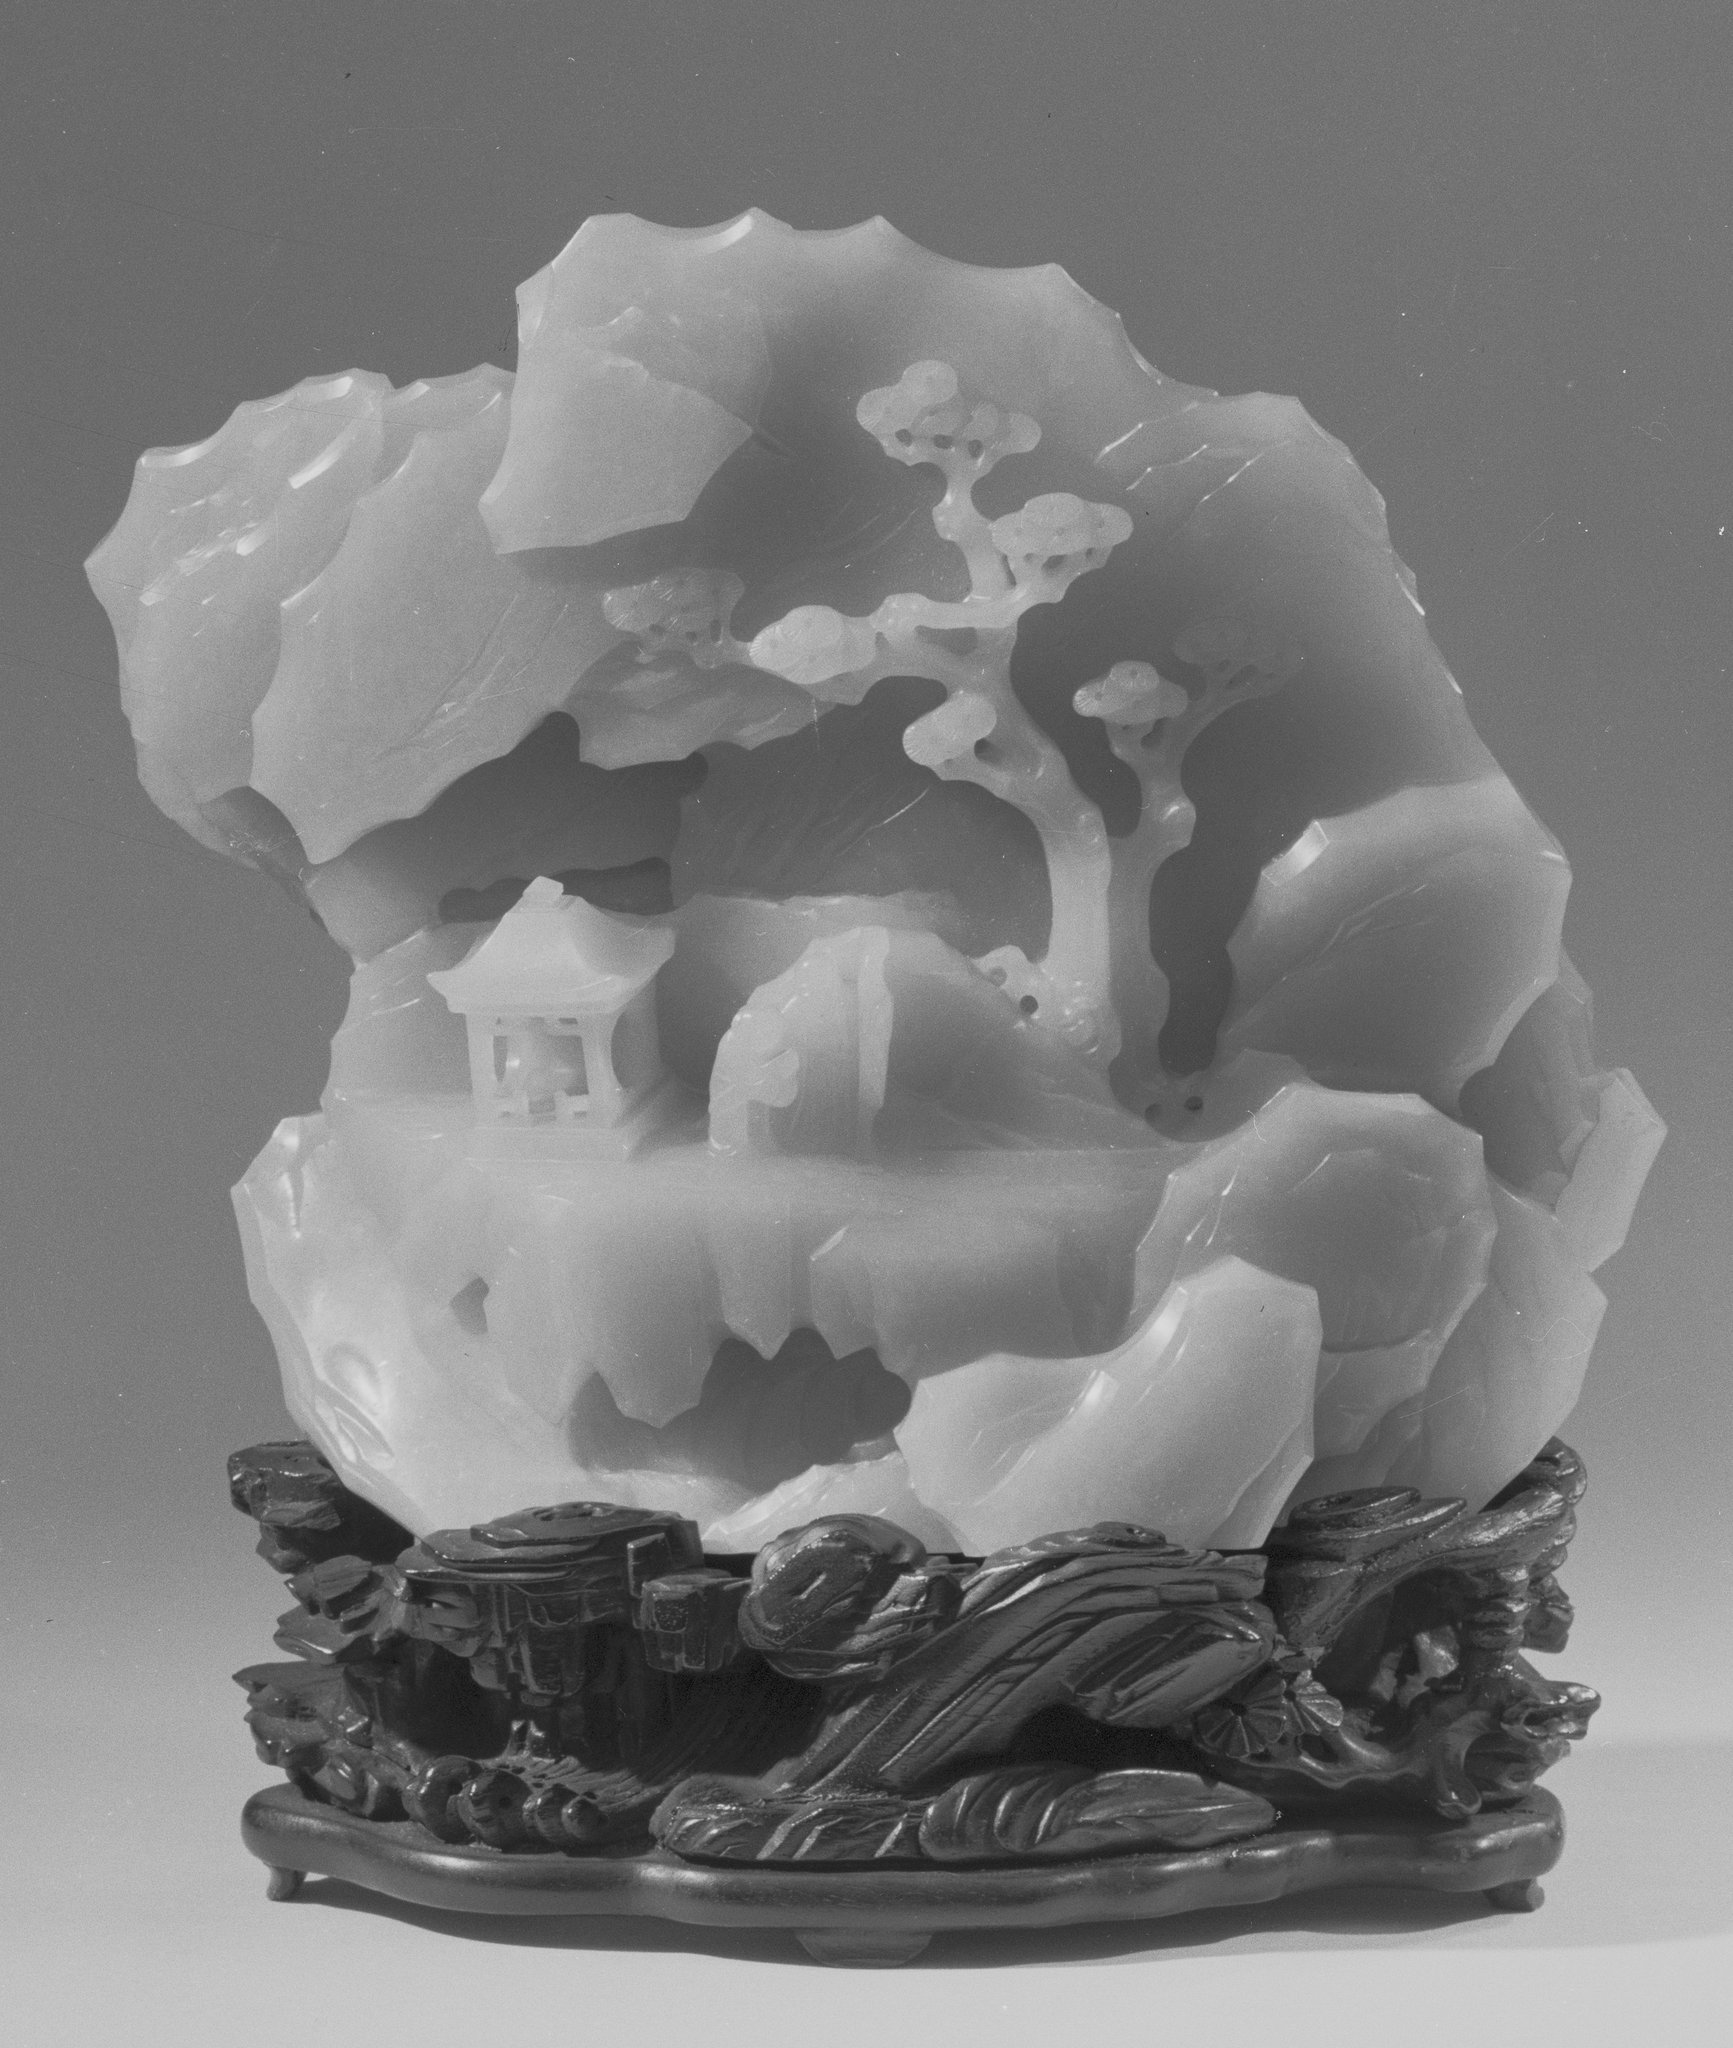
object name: relief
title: Scholars in a landscape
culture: chinese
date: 1701-1800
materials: jade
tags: mountains,trees